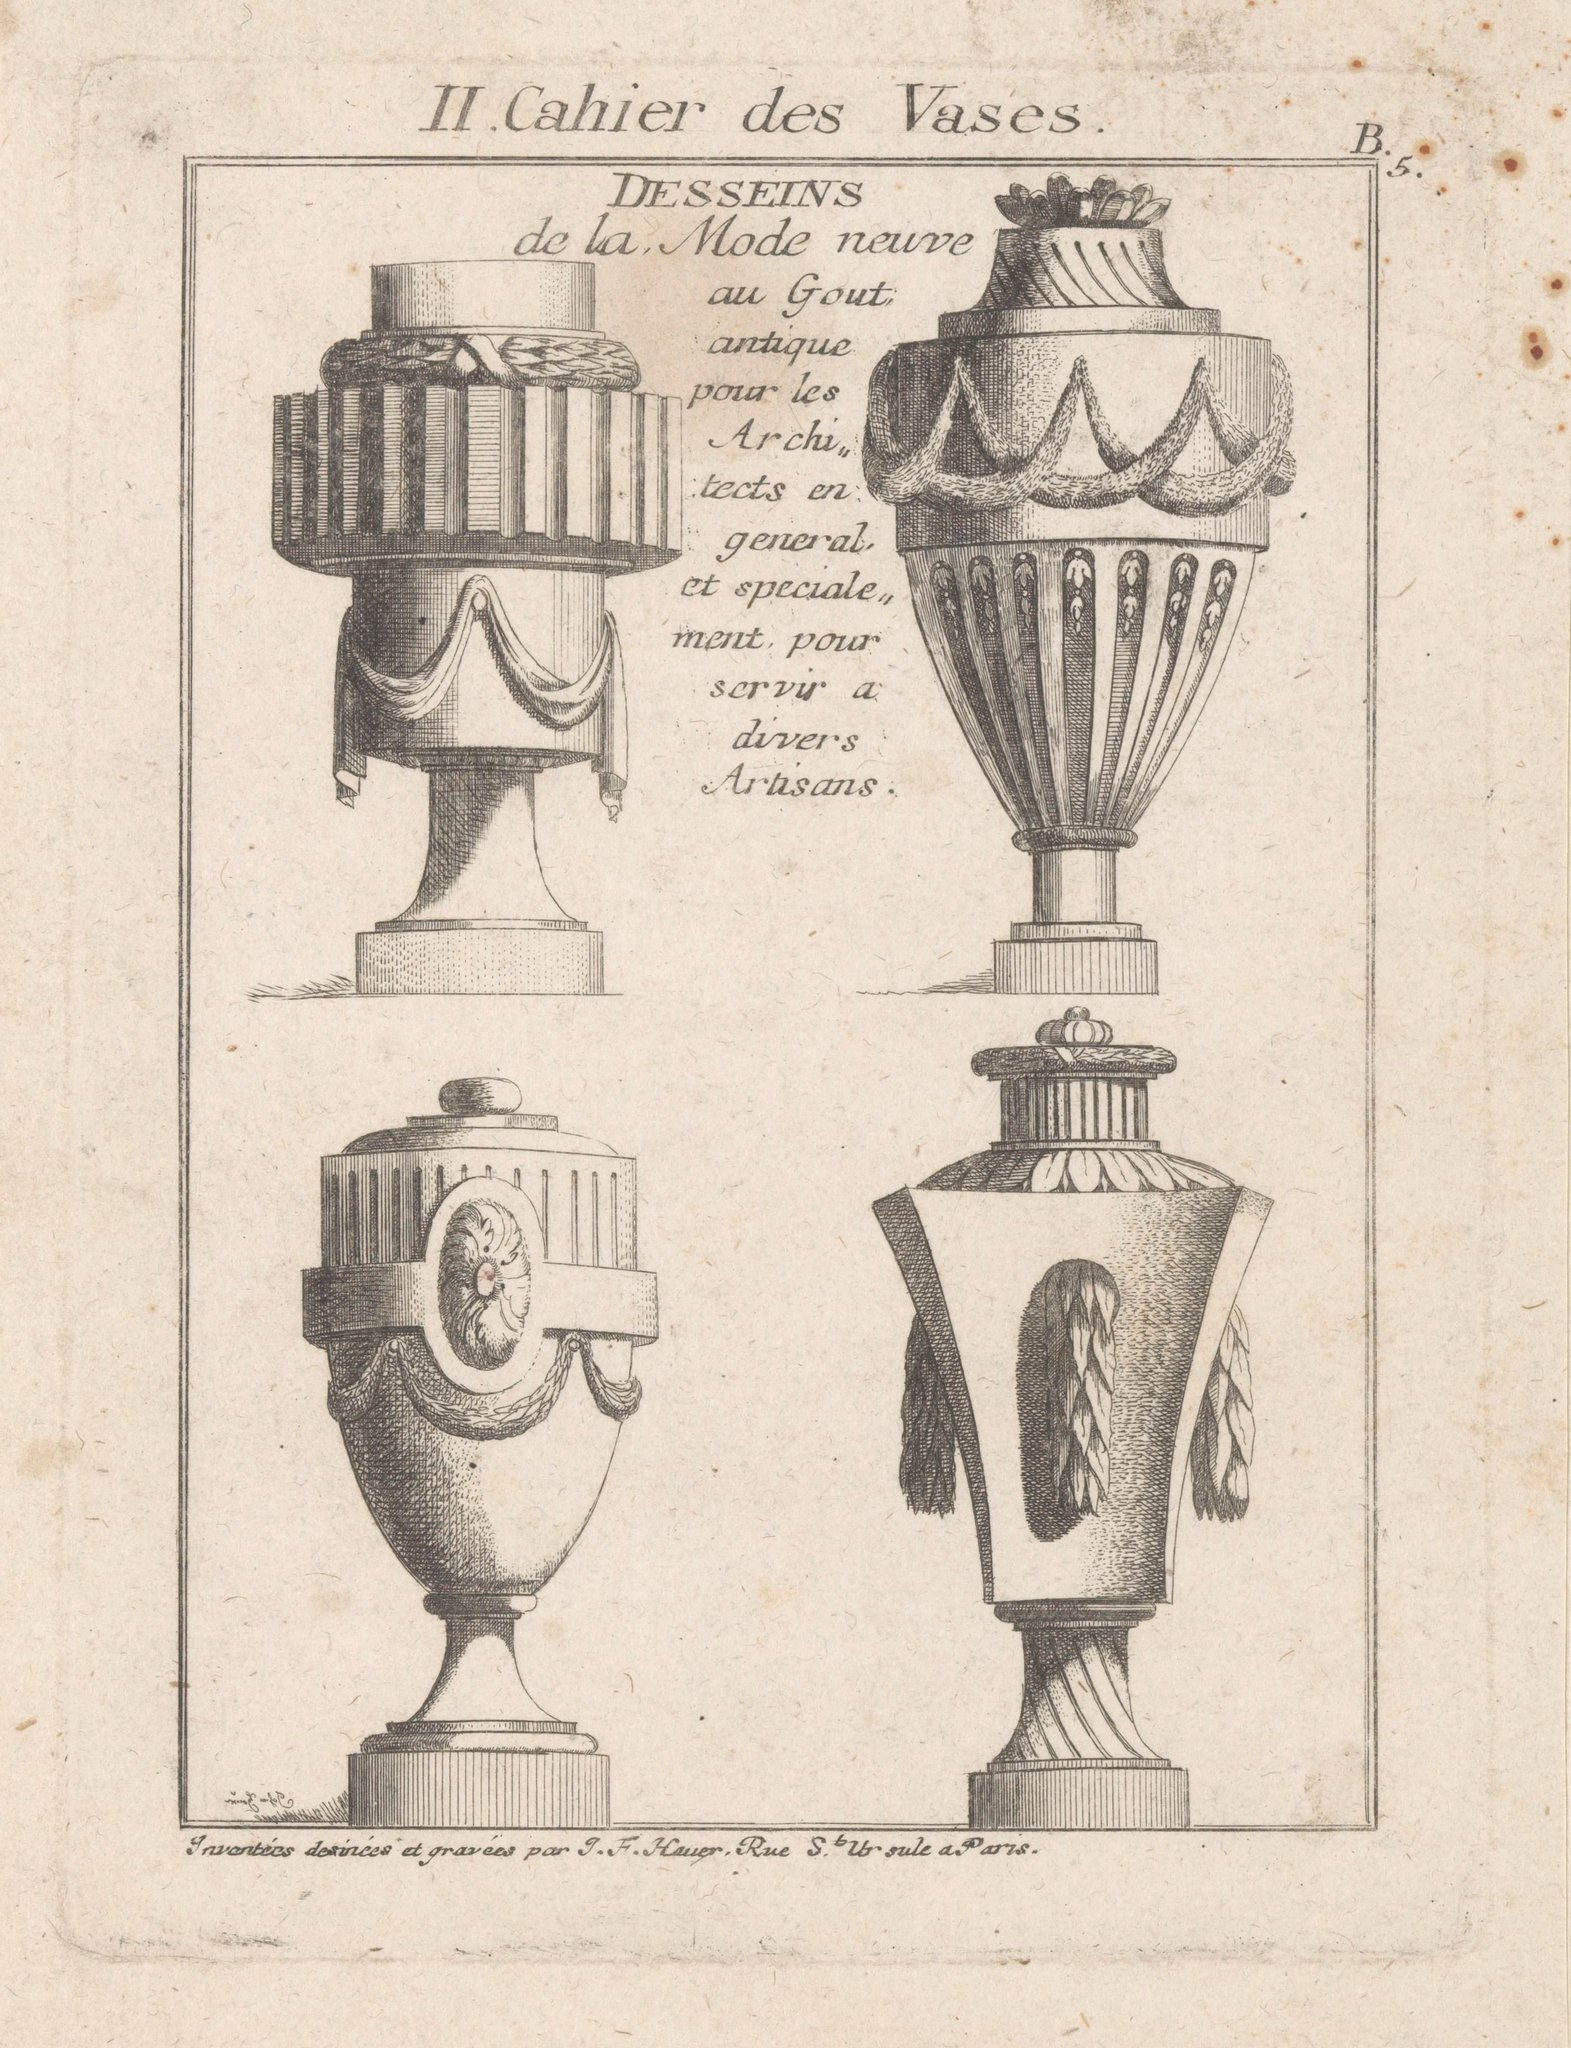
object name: titelprent, frontispice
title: Desseins de la Mode neuve au Gout antique (...)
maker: johann thomas hauer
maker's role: print maker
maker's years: 1748-1820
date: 1758-1820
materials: paper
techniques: engraving, etching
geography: paris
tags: vase ~ ornament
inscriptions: collector's mark: Lugt 2760, collector's mark: Lugt 2228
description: Ontwerpen voor vier vazen met guirlandes en ornamenten.